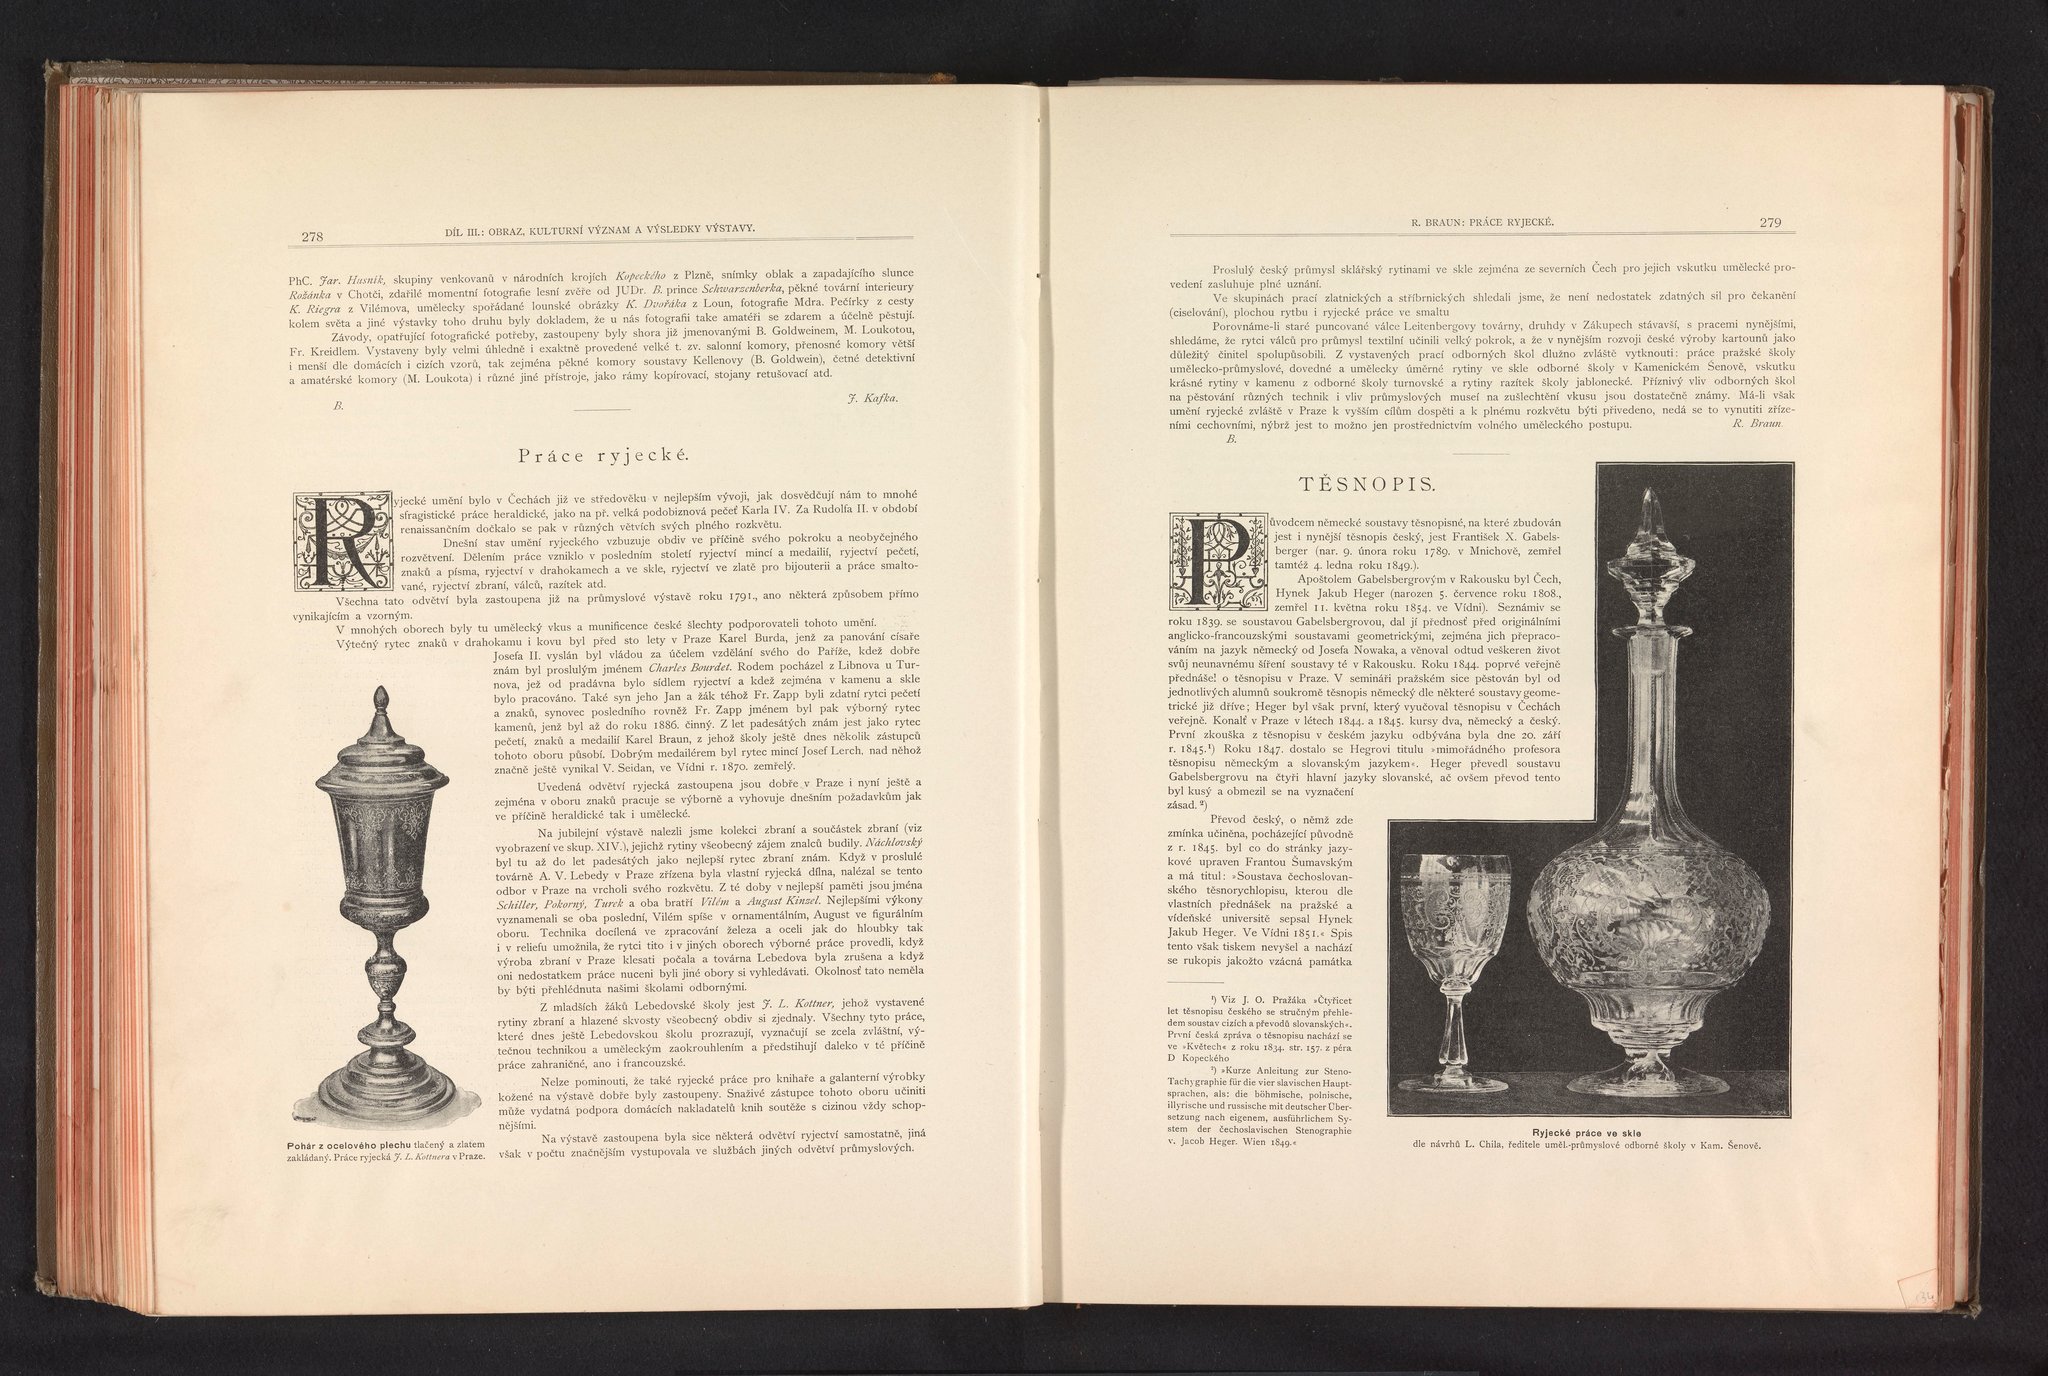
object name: photomechanical print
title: Kelk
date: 1890-1895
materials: paper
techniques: autotype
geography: prague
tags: chalice